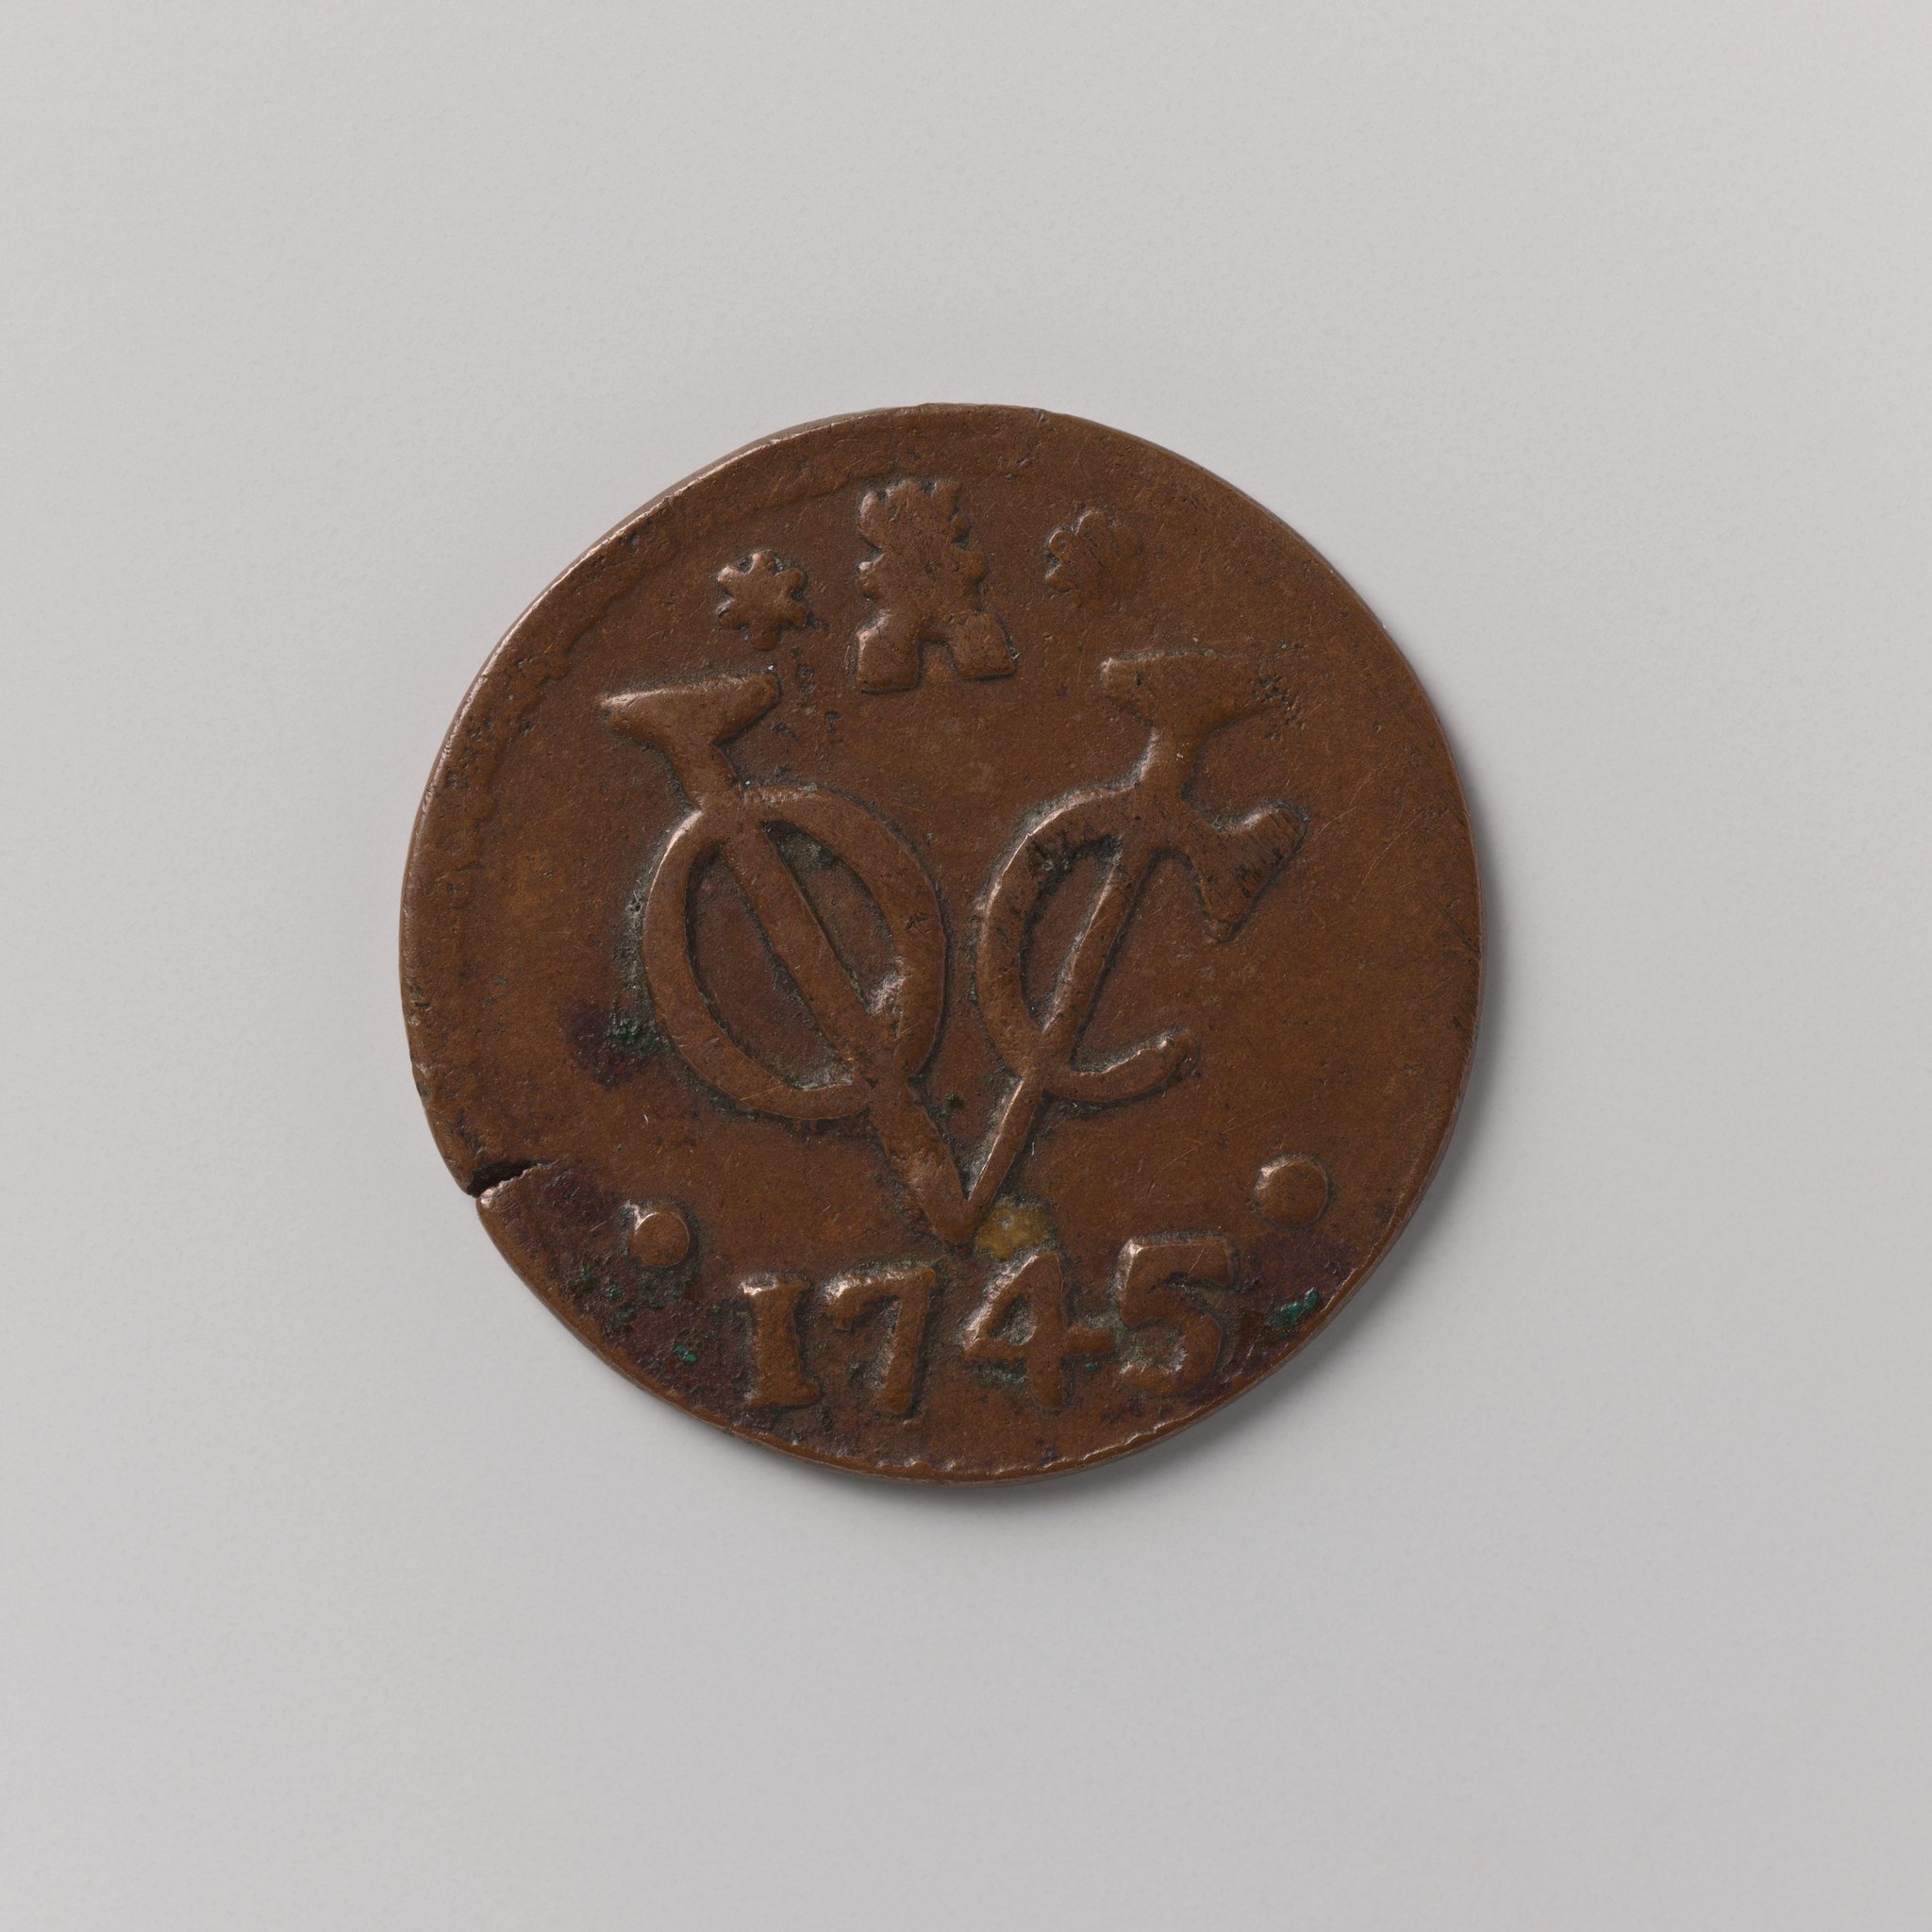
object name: coin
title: Duit van de VOC uit Zeeland, 1745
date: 1745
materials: copper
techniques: striking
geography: middelburg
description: Koperen munt. Voorzijde: gekroond wapenschild van Zeeland. Keerzijde: monogram van de VOC, waarboven muntteken en waaronder jaartal. Gladde rand.